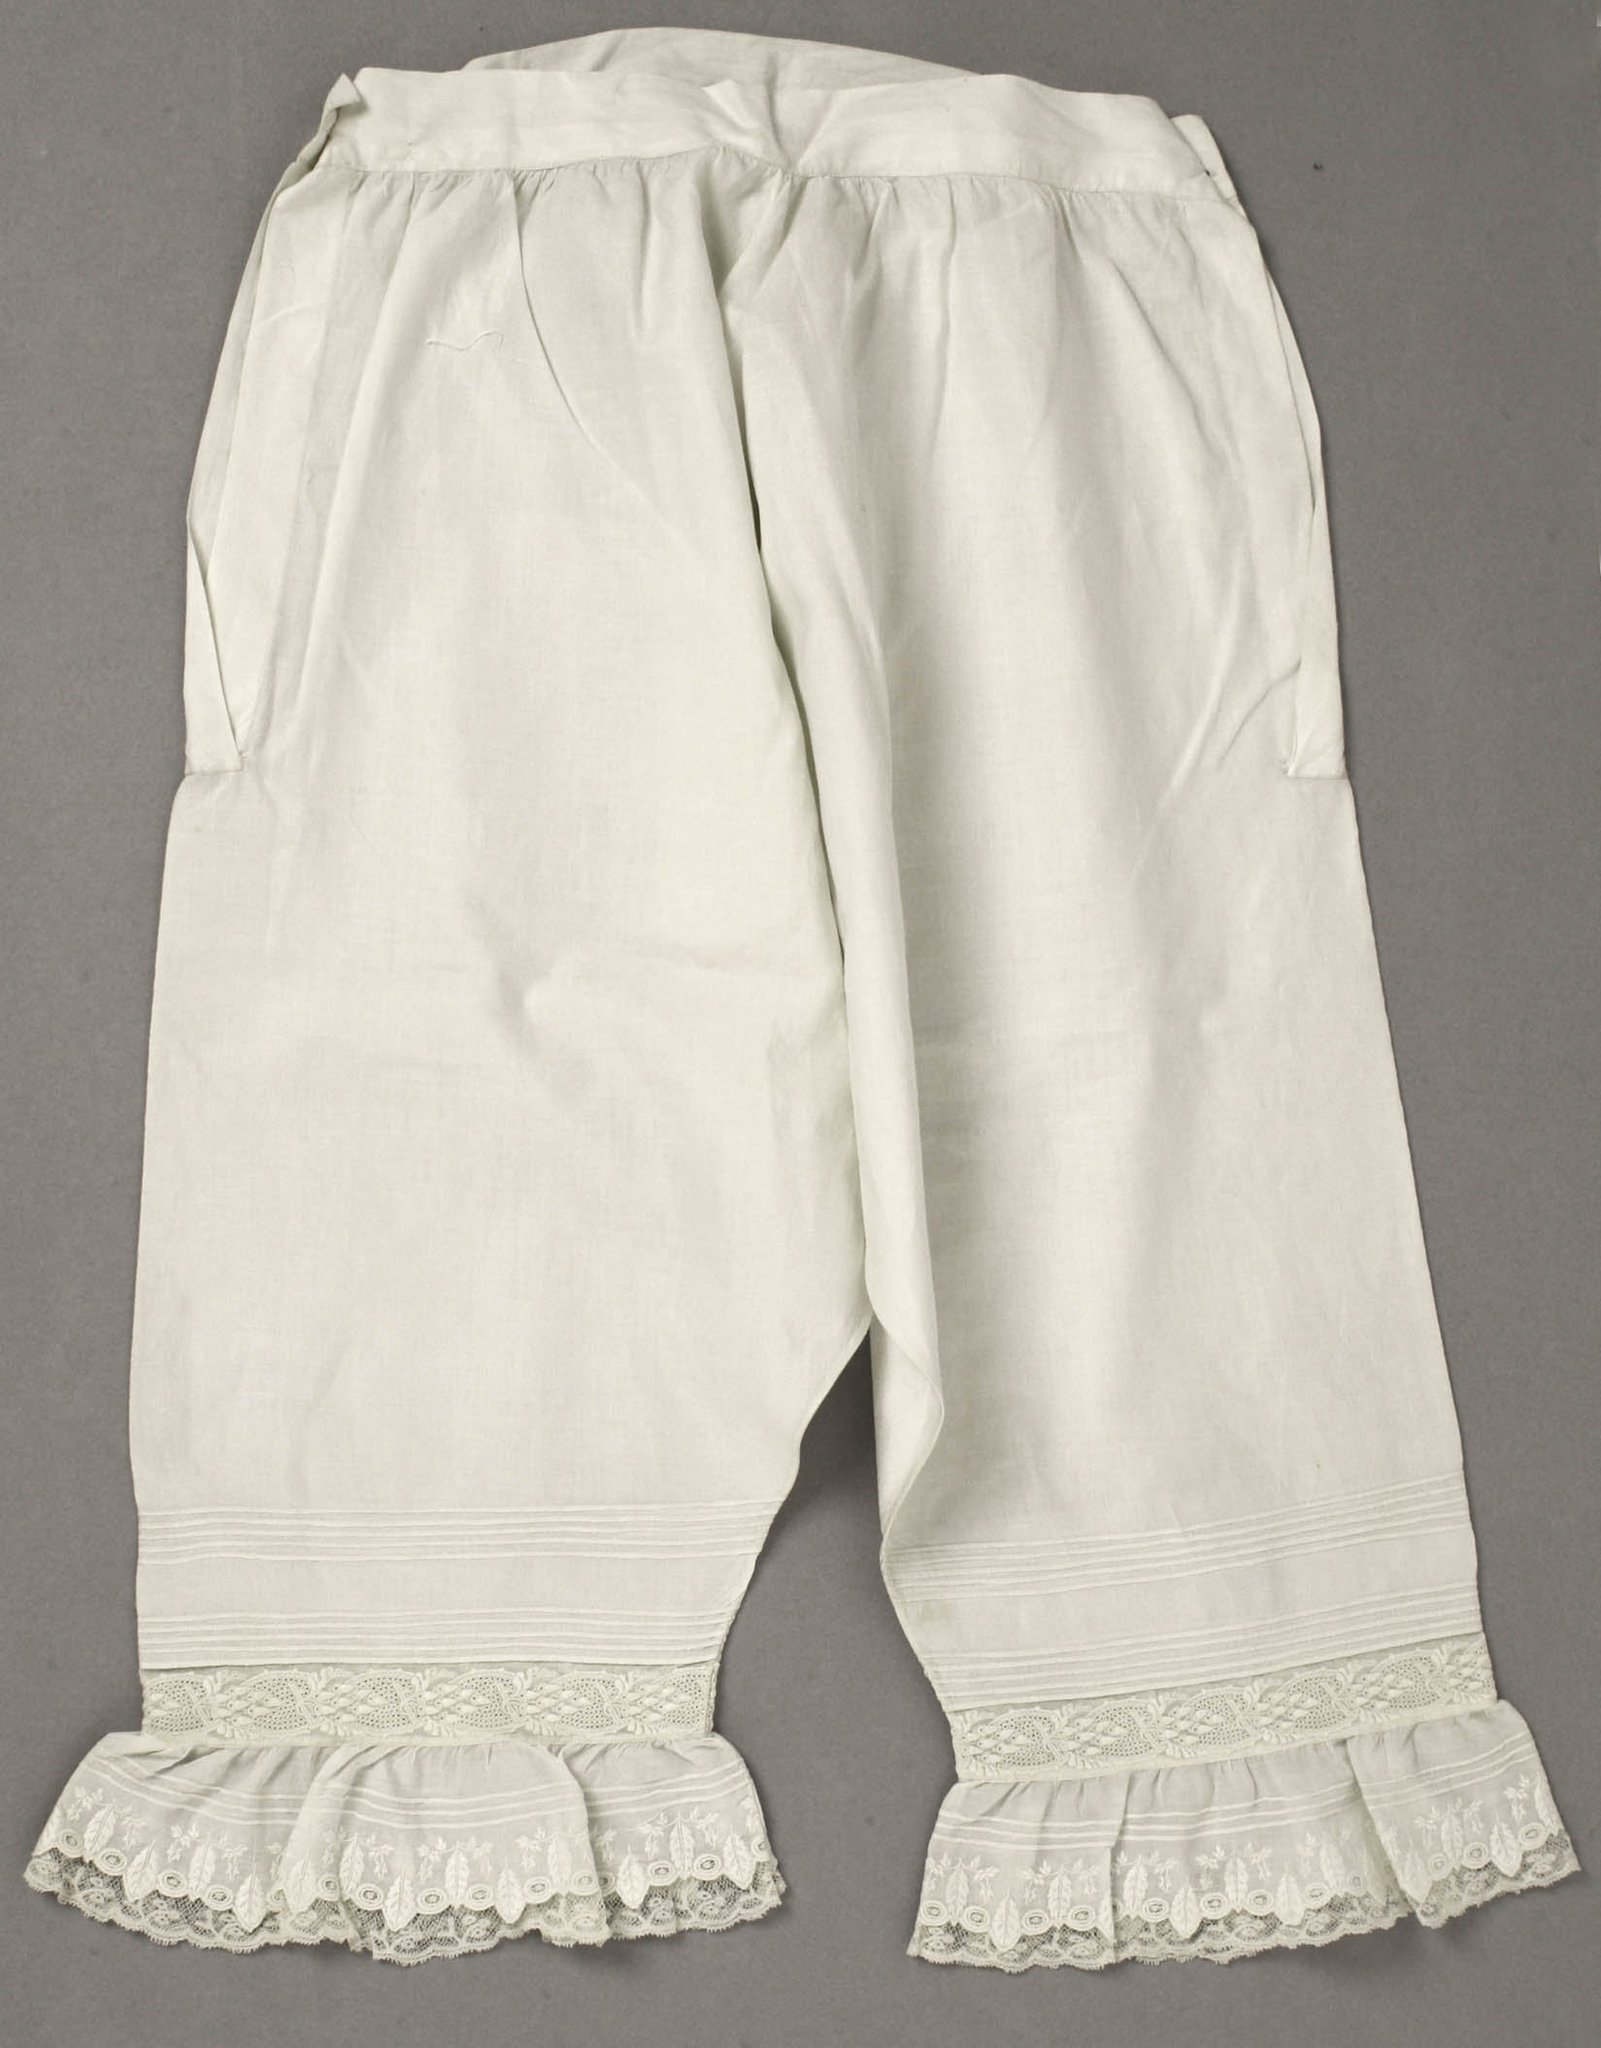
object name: pantalets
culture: american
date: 1860-1869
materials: linen